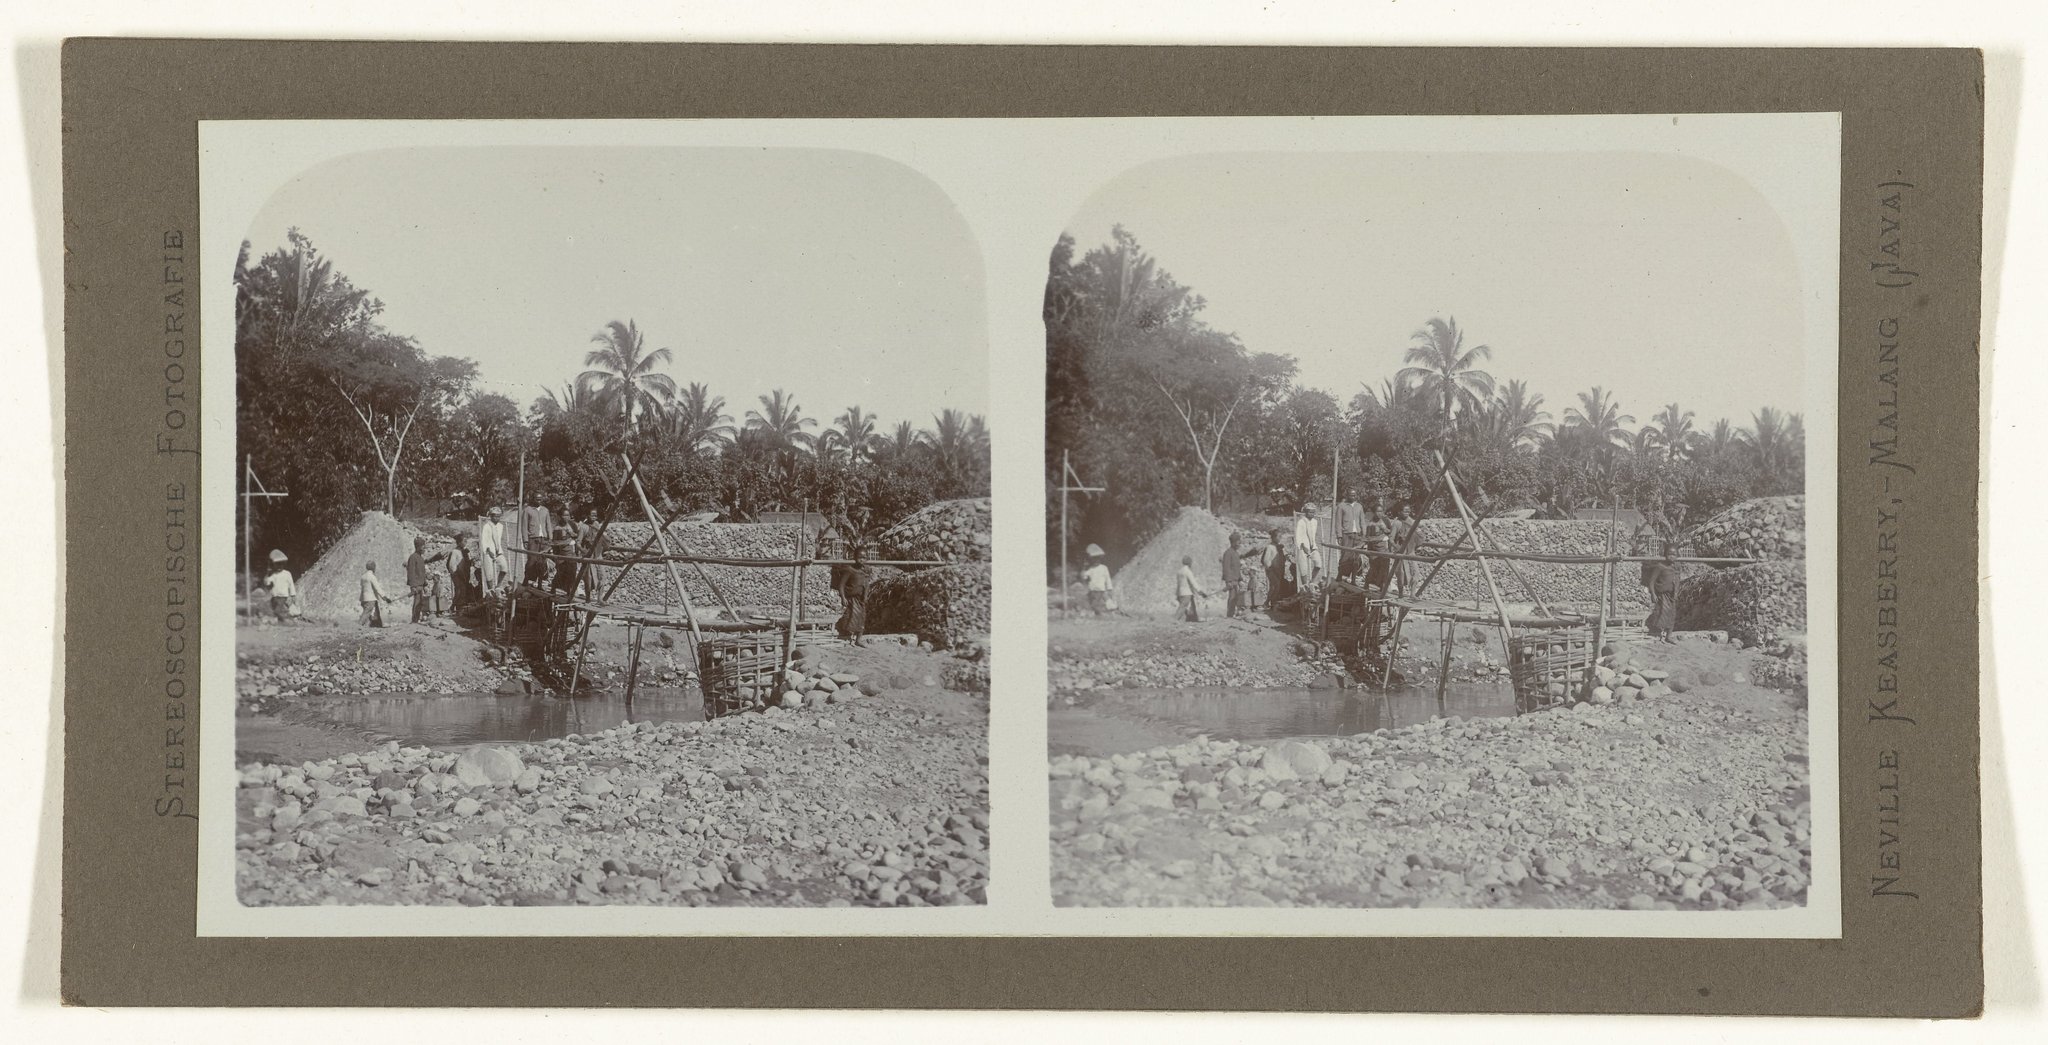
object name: stereograph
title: Mensen op een voetgangersbrug bestaande uit houtenpalen over een water.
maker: neville keasberry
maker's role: fotograaf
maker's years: 1866-1944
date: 1911-1935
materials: cardboard, paper, photographic support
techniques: albumen print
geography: malang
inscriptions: inscription: ‘Stereoscopische Fotografie’, signature: ‘Neville Keasberry, Malang (Java)’